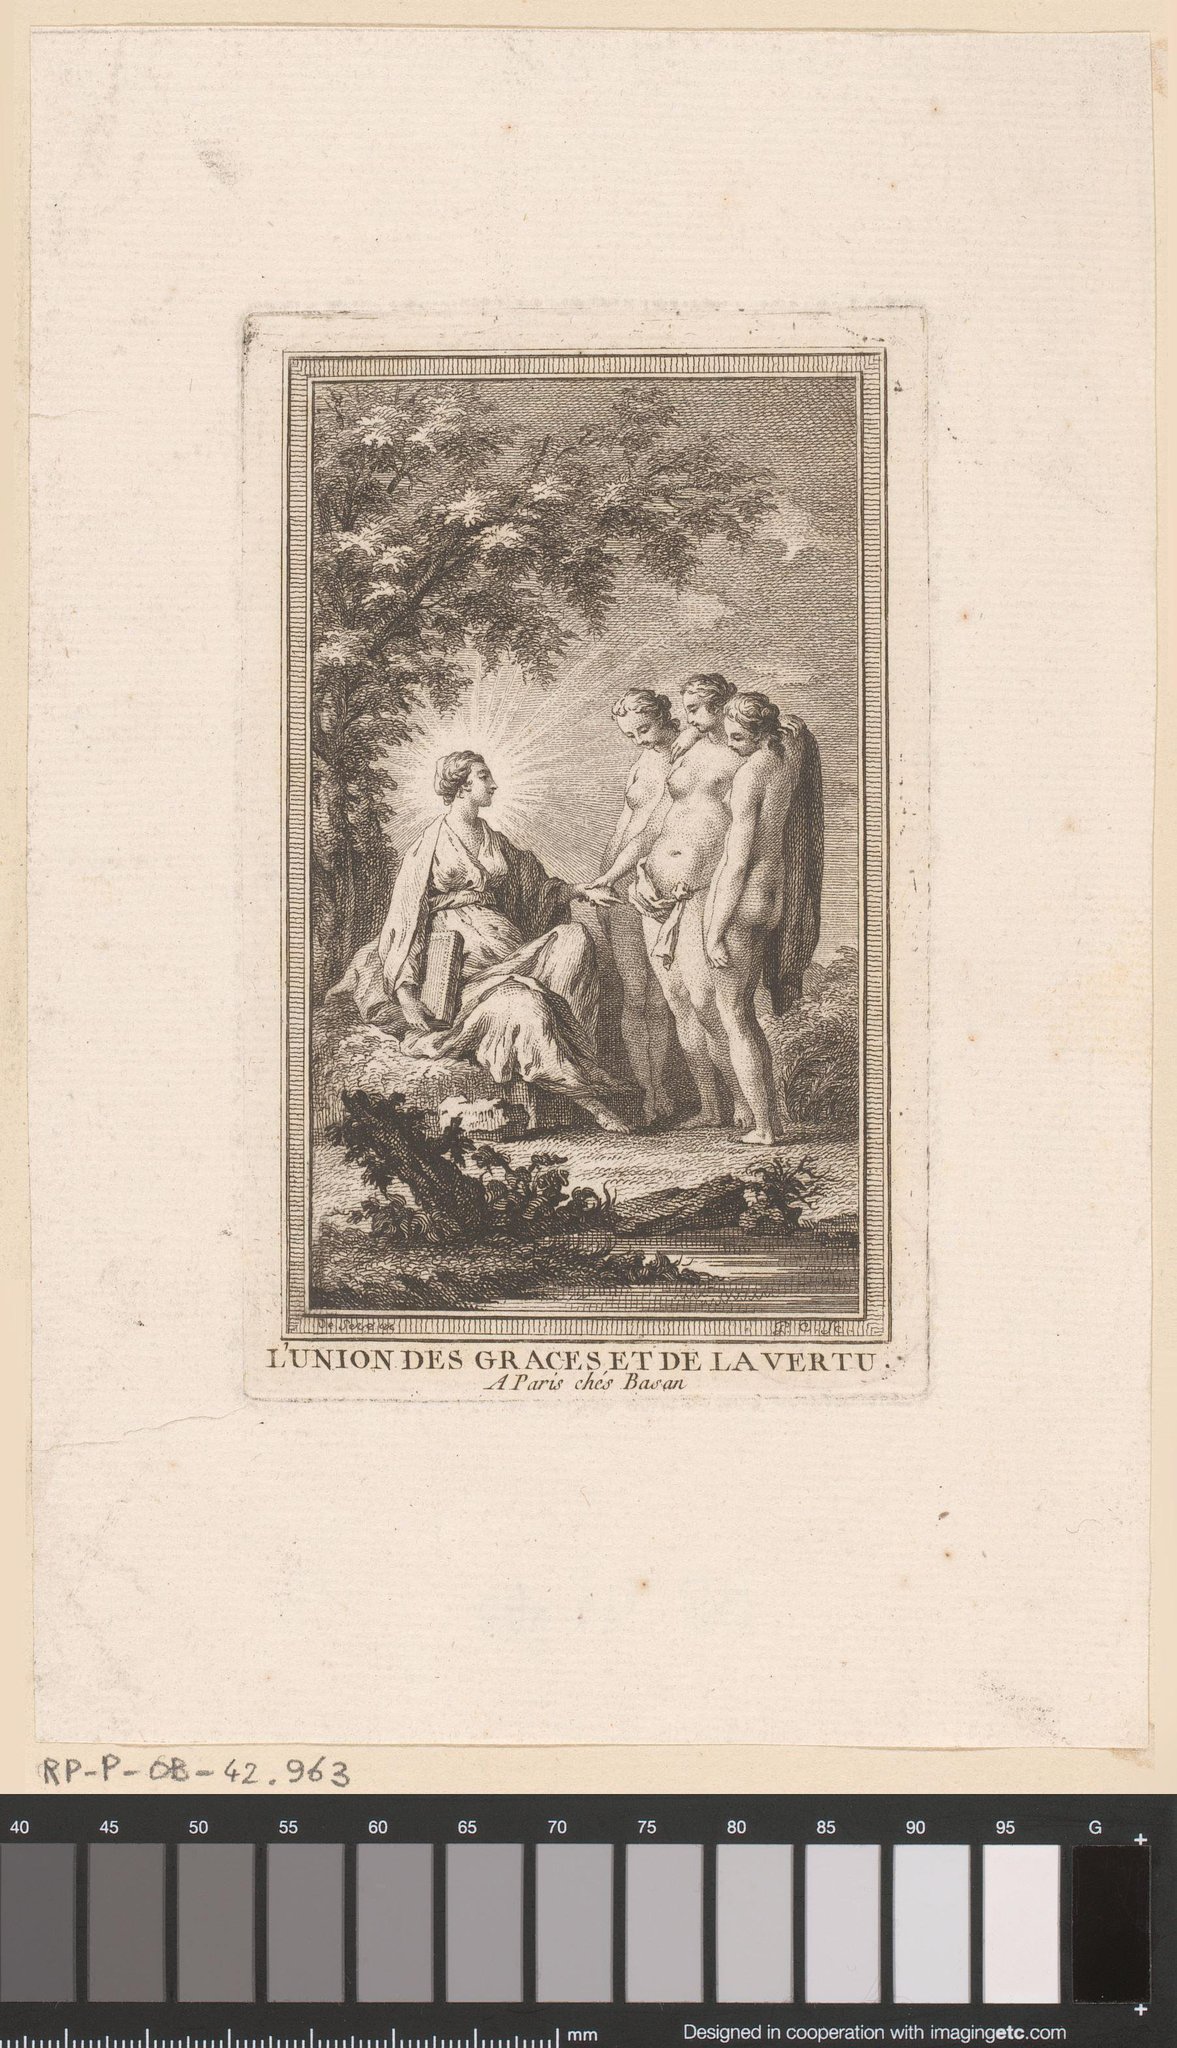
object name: print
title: L'Union des Graces et de la Vertu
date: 1746-1763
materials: paper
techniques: etching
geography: paris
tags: graces (charites), generally three in number; 'gratie' (ripa)